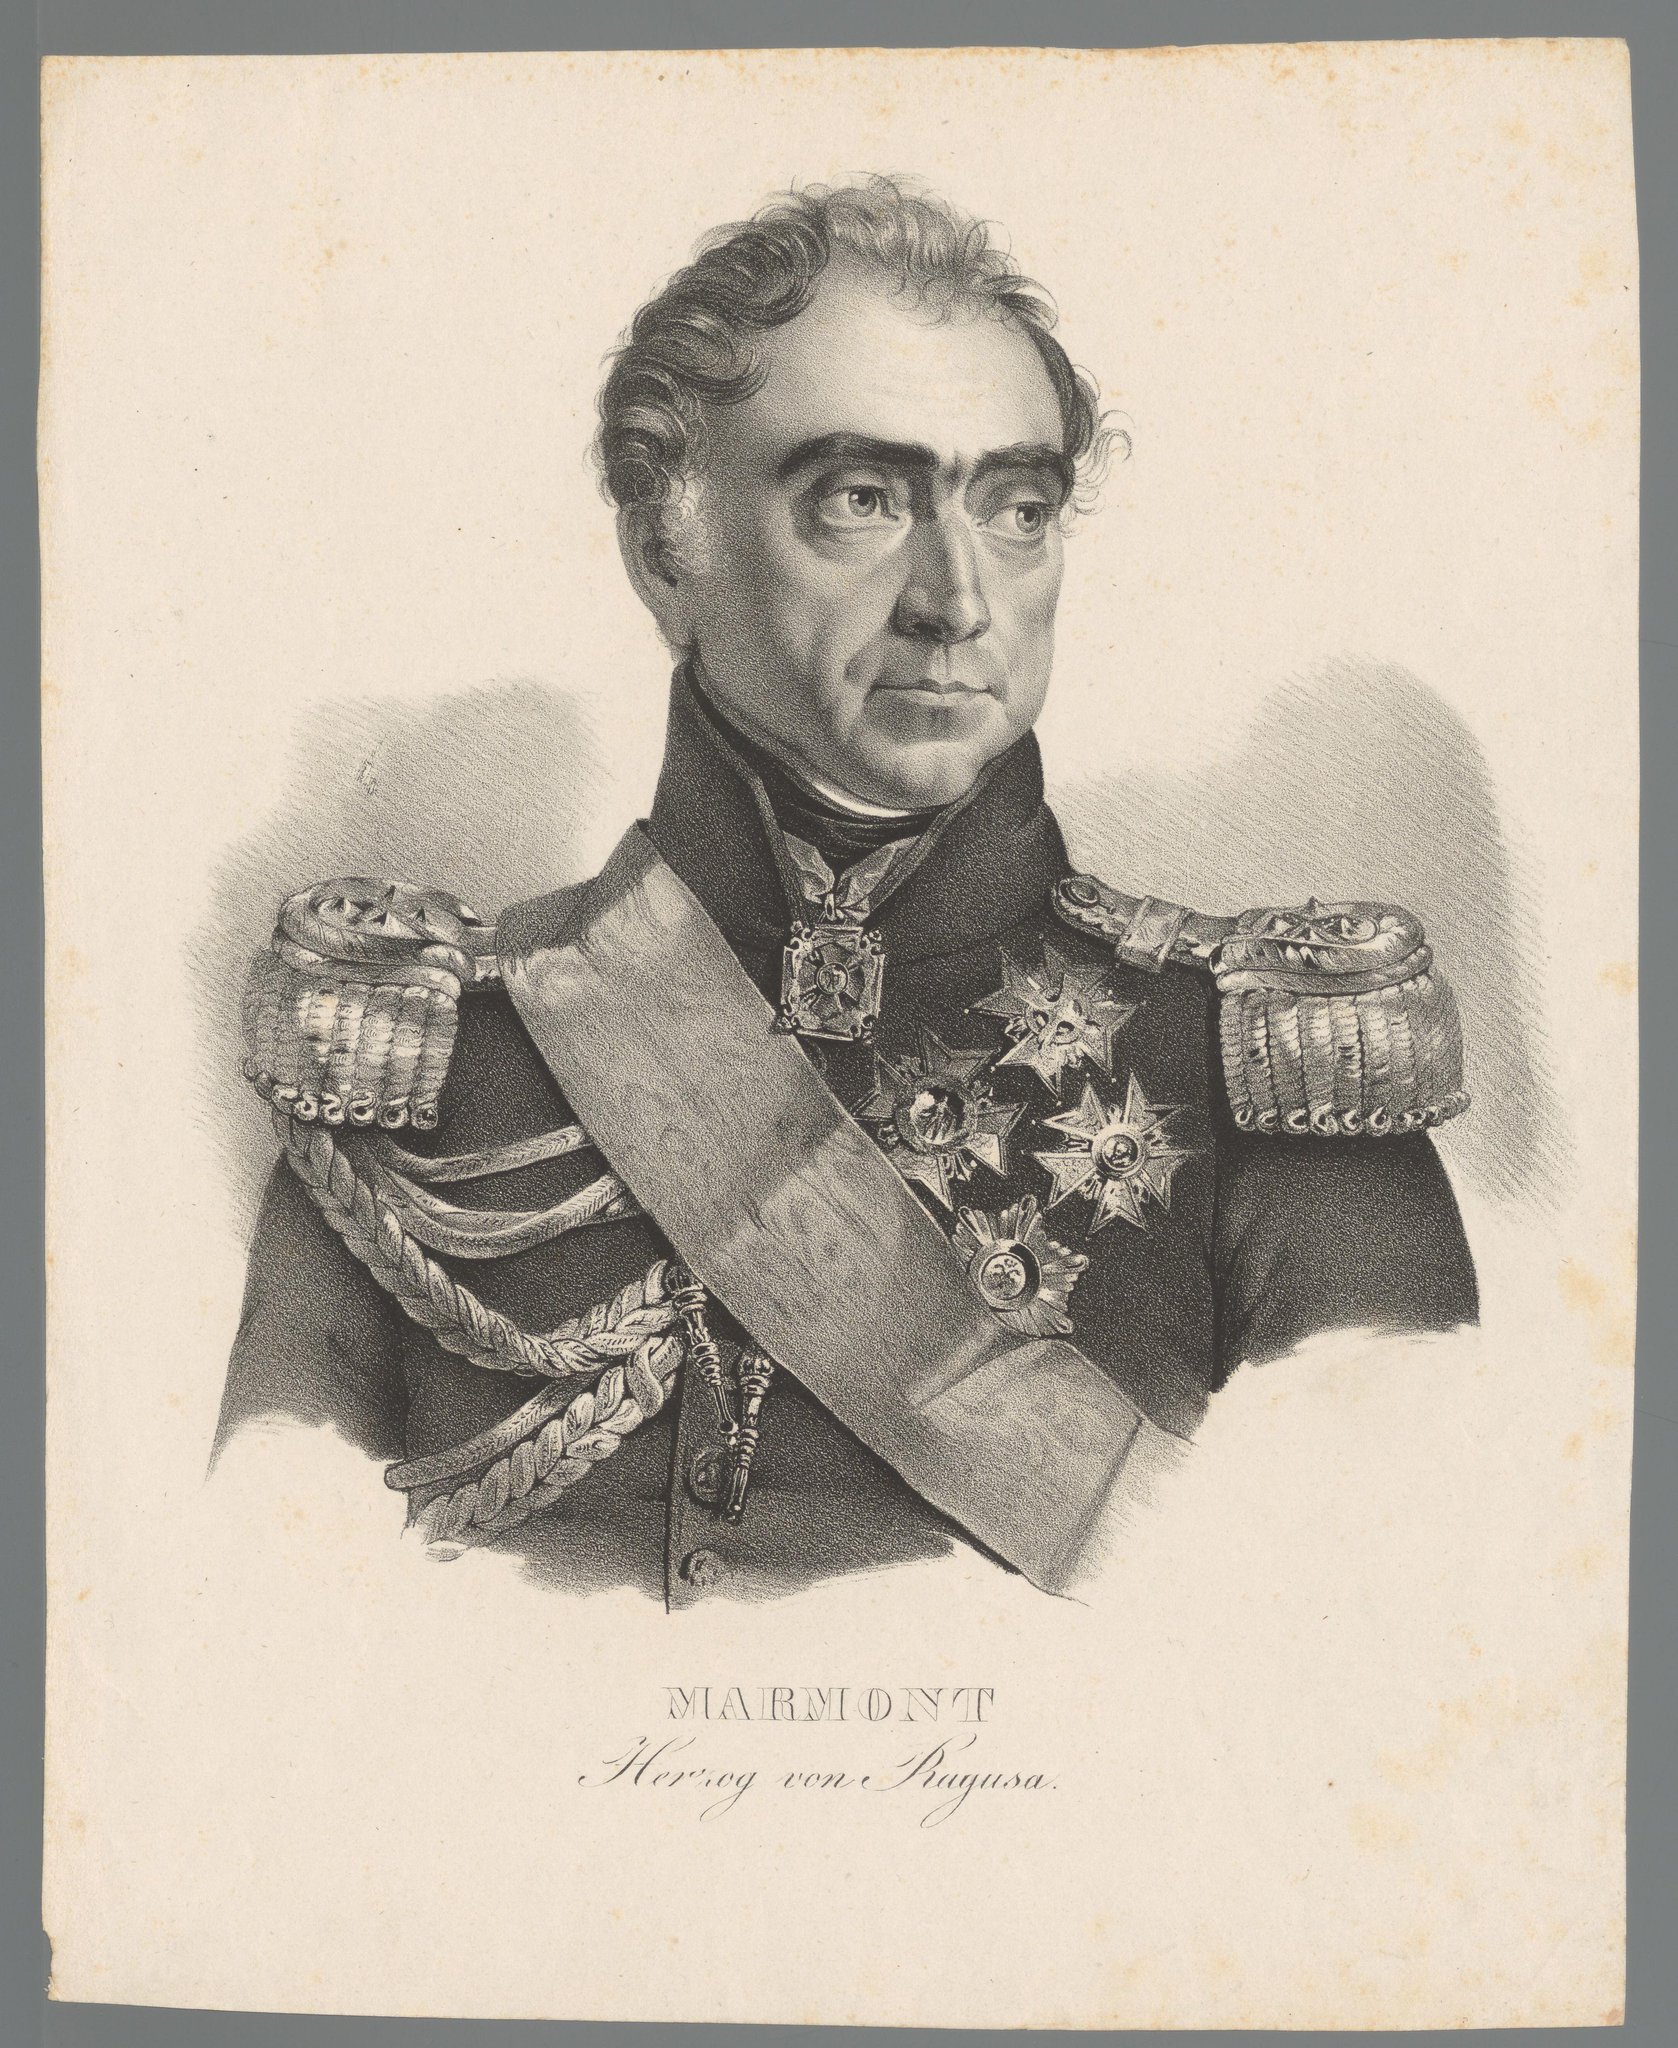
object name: print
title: Portret van Auguste-Frédéric-Louis Viesse de Marmont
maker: august selb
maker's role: print maker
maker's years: 1812-1859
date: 1822-1859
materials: paper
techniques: lithograph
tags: adult man, historical persons, (military) uniforms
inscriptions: collector's mark: Lugt 2228